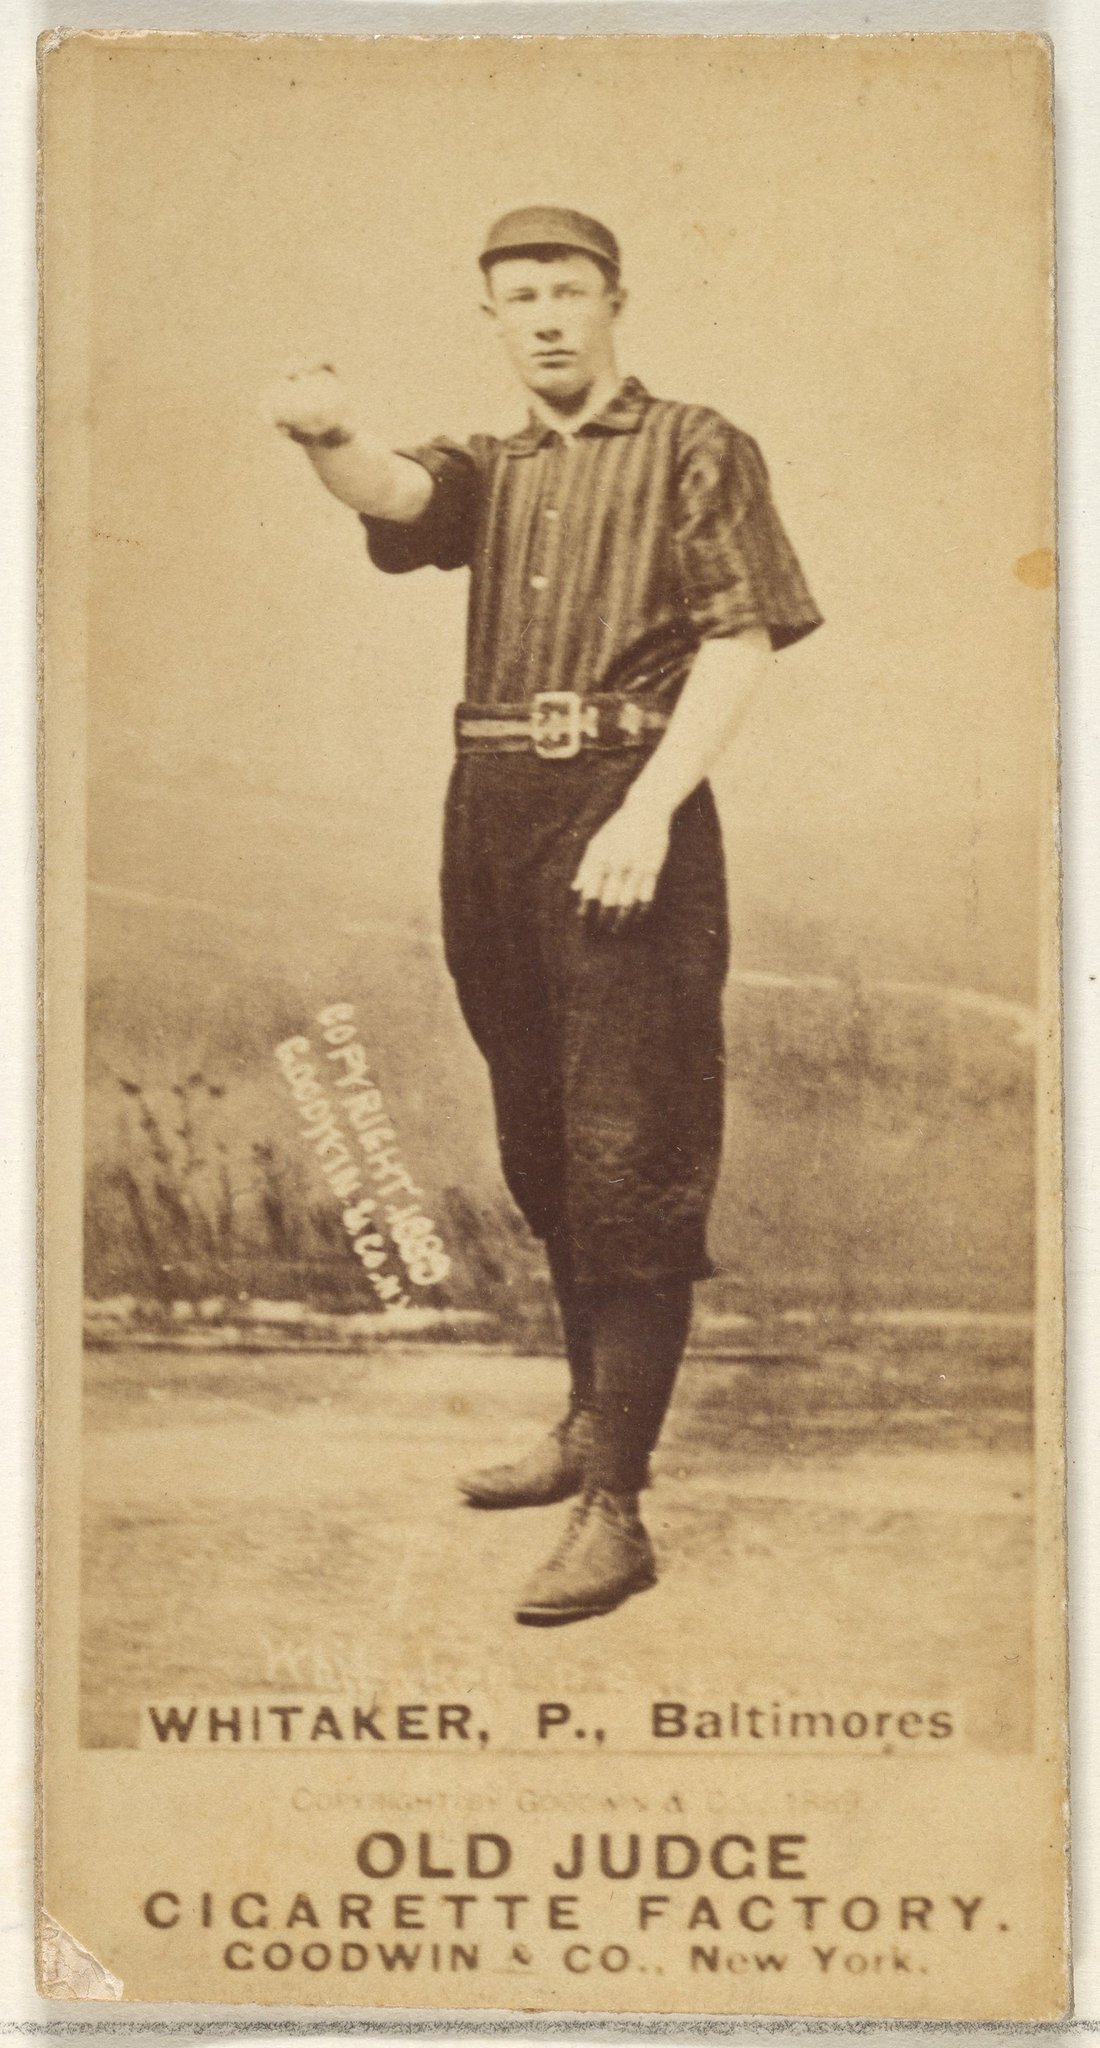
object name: baseball card, photograph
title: Whitaker, Pitcher, Baltimore Orioles, from the Old Judge series (N172) for Old Judge Cigarettes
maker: goodwin & company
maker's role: publisher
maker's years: 1850-1950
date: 1889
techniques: albumen silver print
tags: men,portraits,baseball,athletes